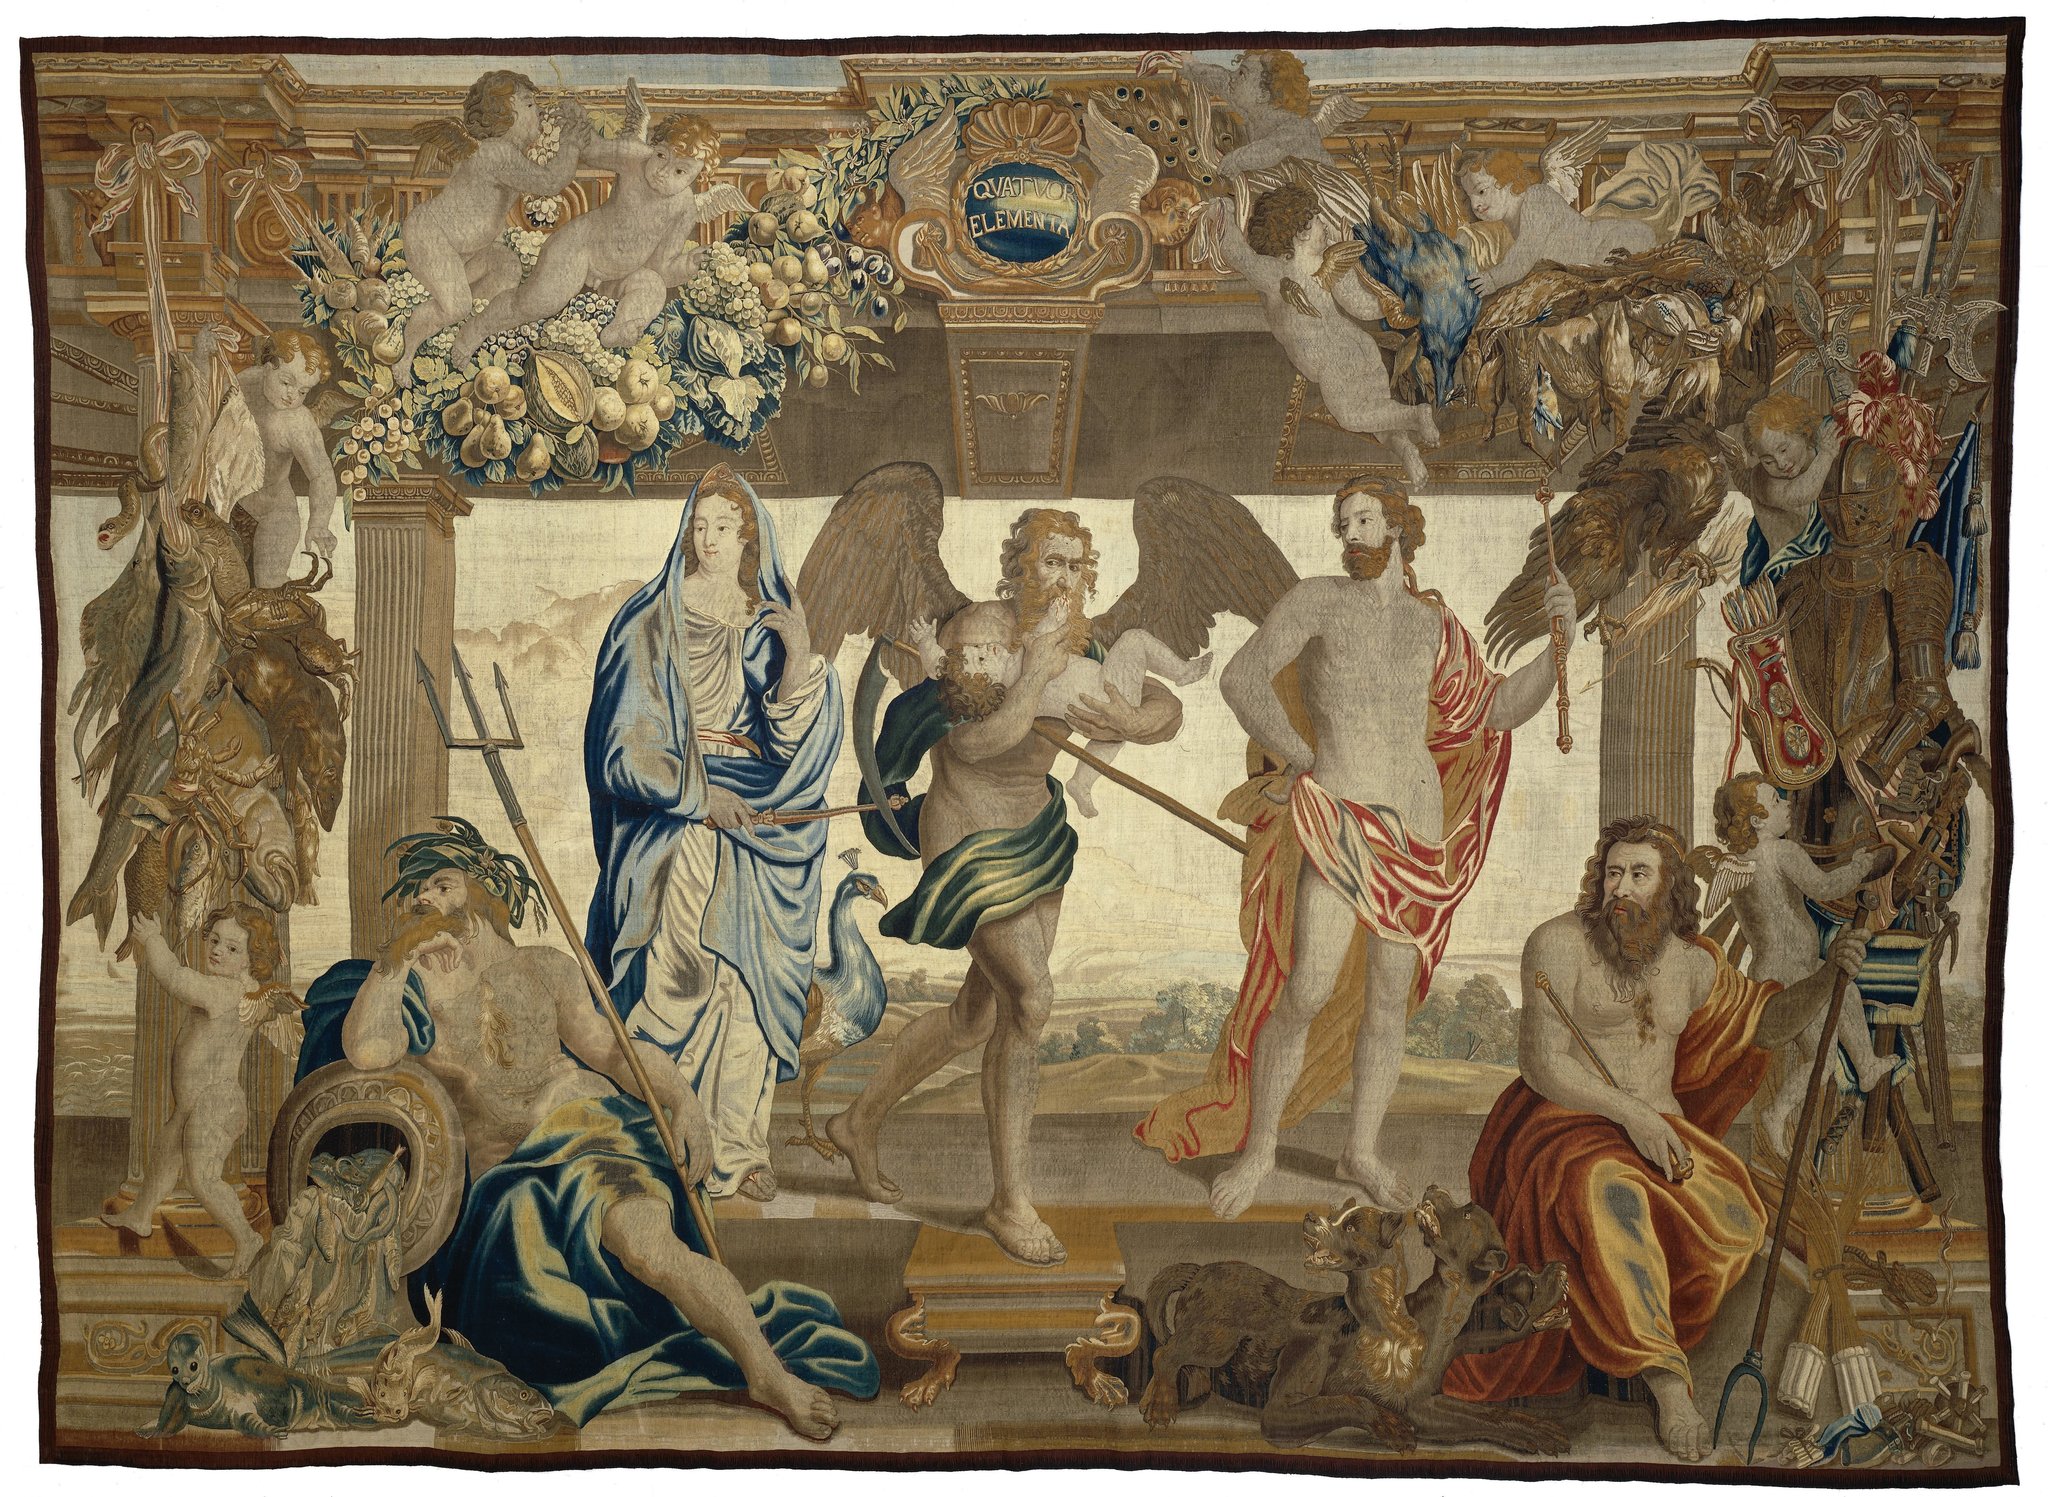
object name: tapestry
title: De vier elementen en de tijd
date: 1650-1680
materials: metal thread, silk, wool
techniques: tapestry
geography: antwerp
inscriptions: inscription: ‘QVATOR ELEMENTA’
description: Wandtapijt met een allegorische voorstelling van de vier elementen en Chronos uit en uit een serie van tien met de maanden, jaargetijden en elementen, binnen een architecturale omlijsting.